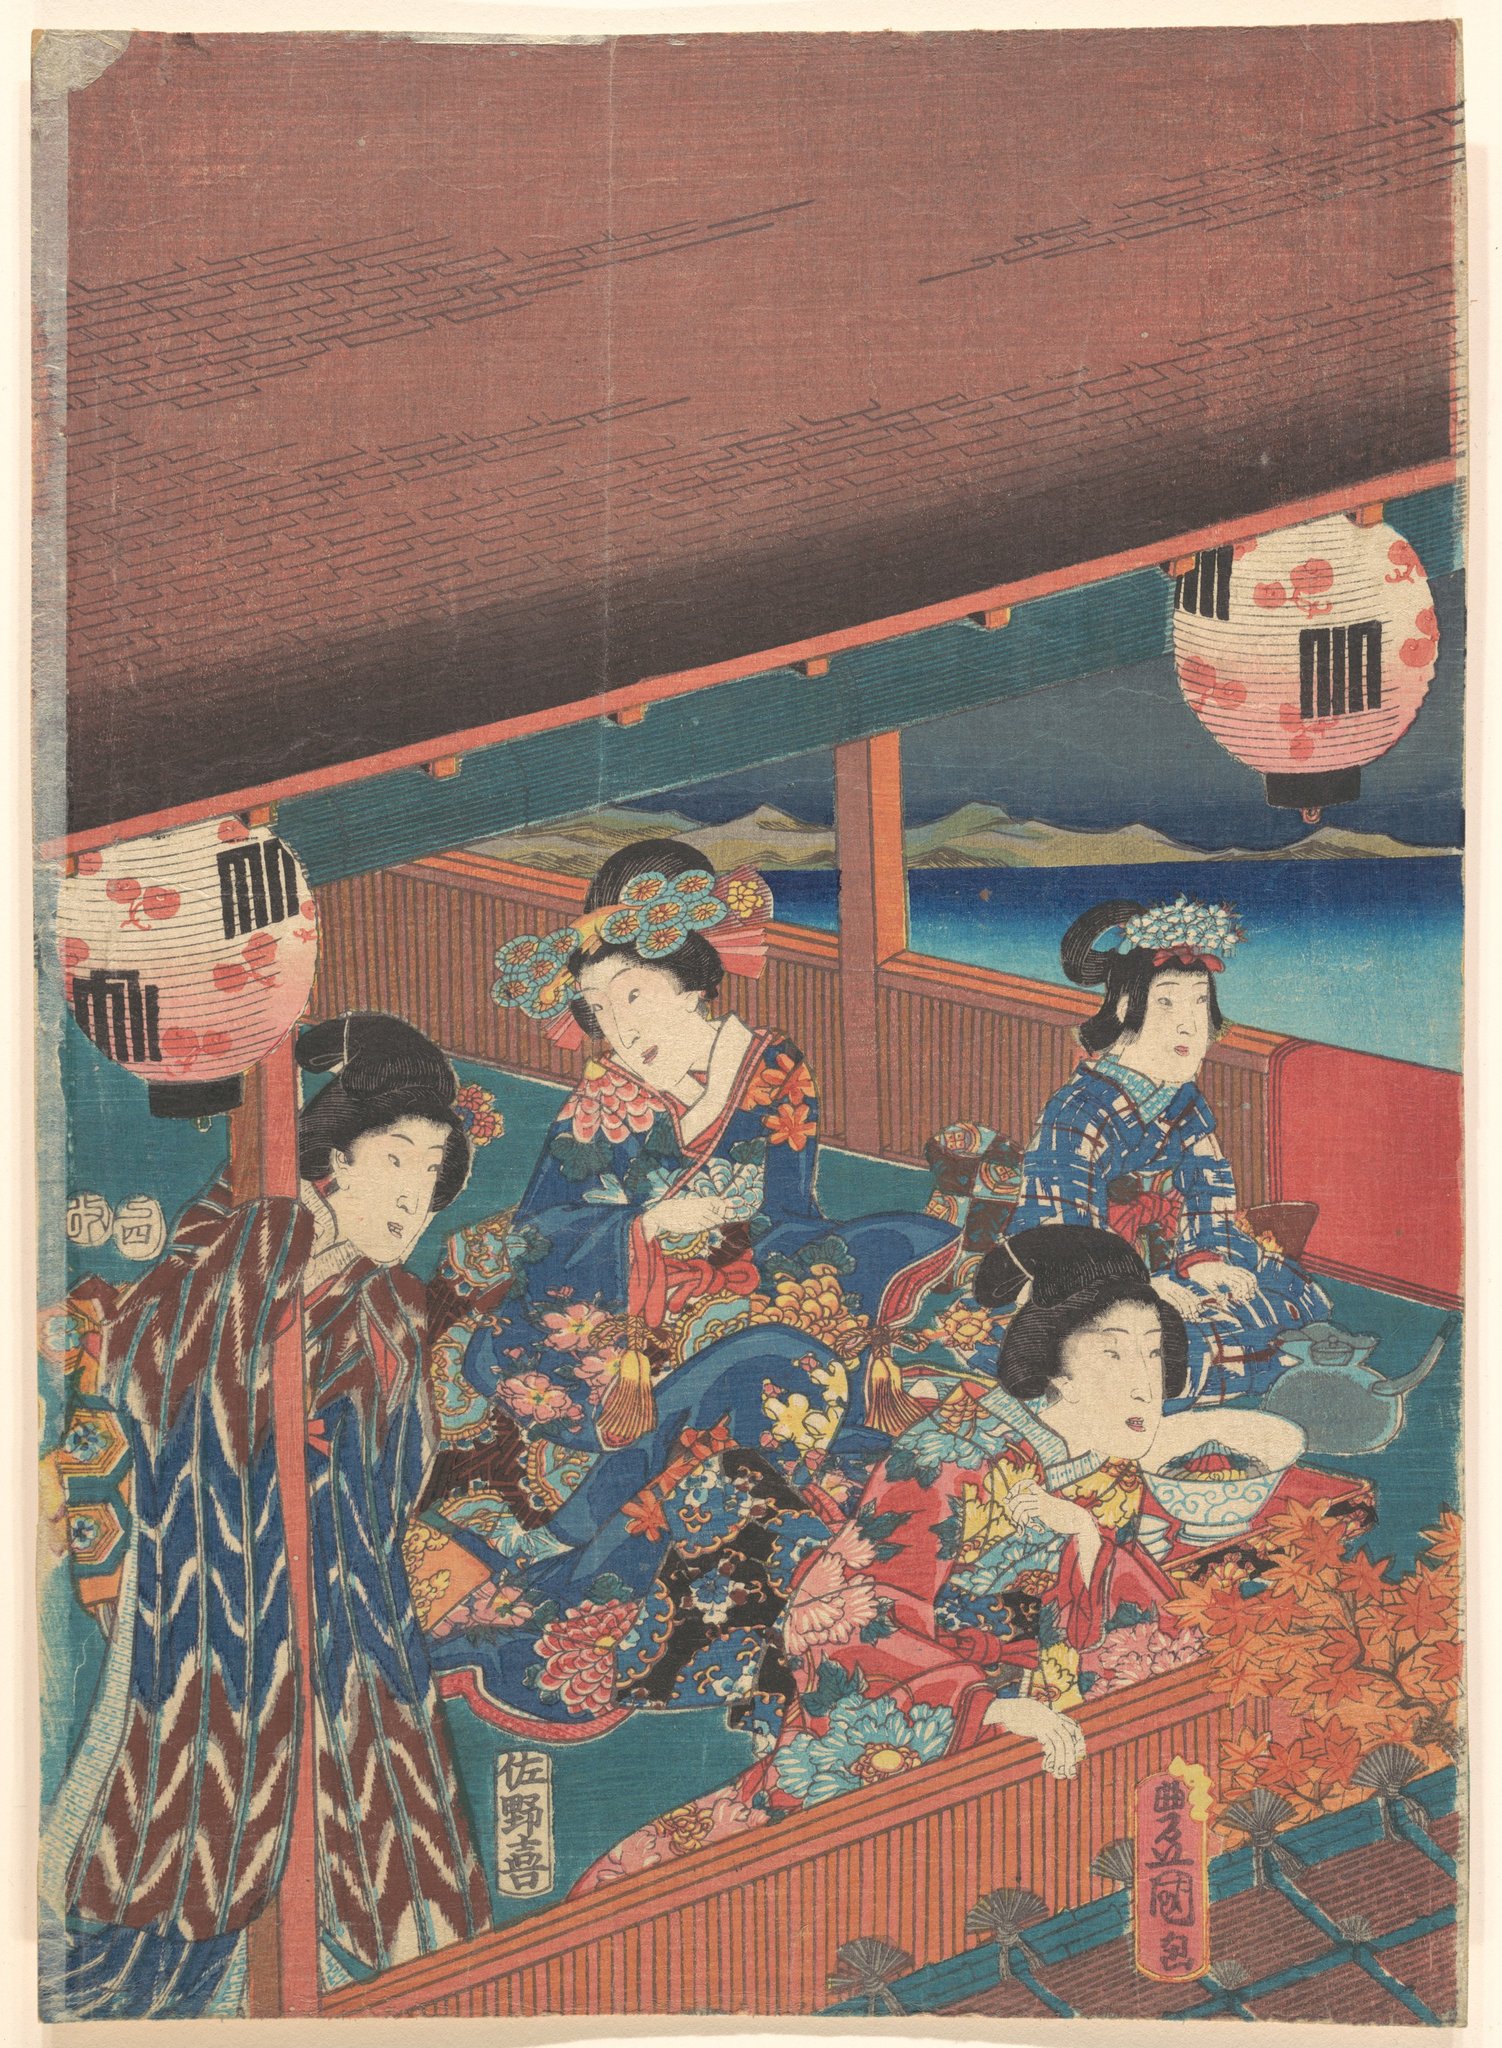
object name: print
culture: japanese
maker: utagawa kunisada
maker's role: artist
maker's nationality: japanese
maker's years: 1786-1864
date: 1786-1854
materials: ink, paper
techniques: woodblock print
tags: women